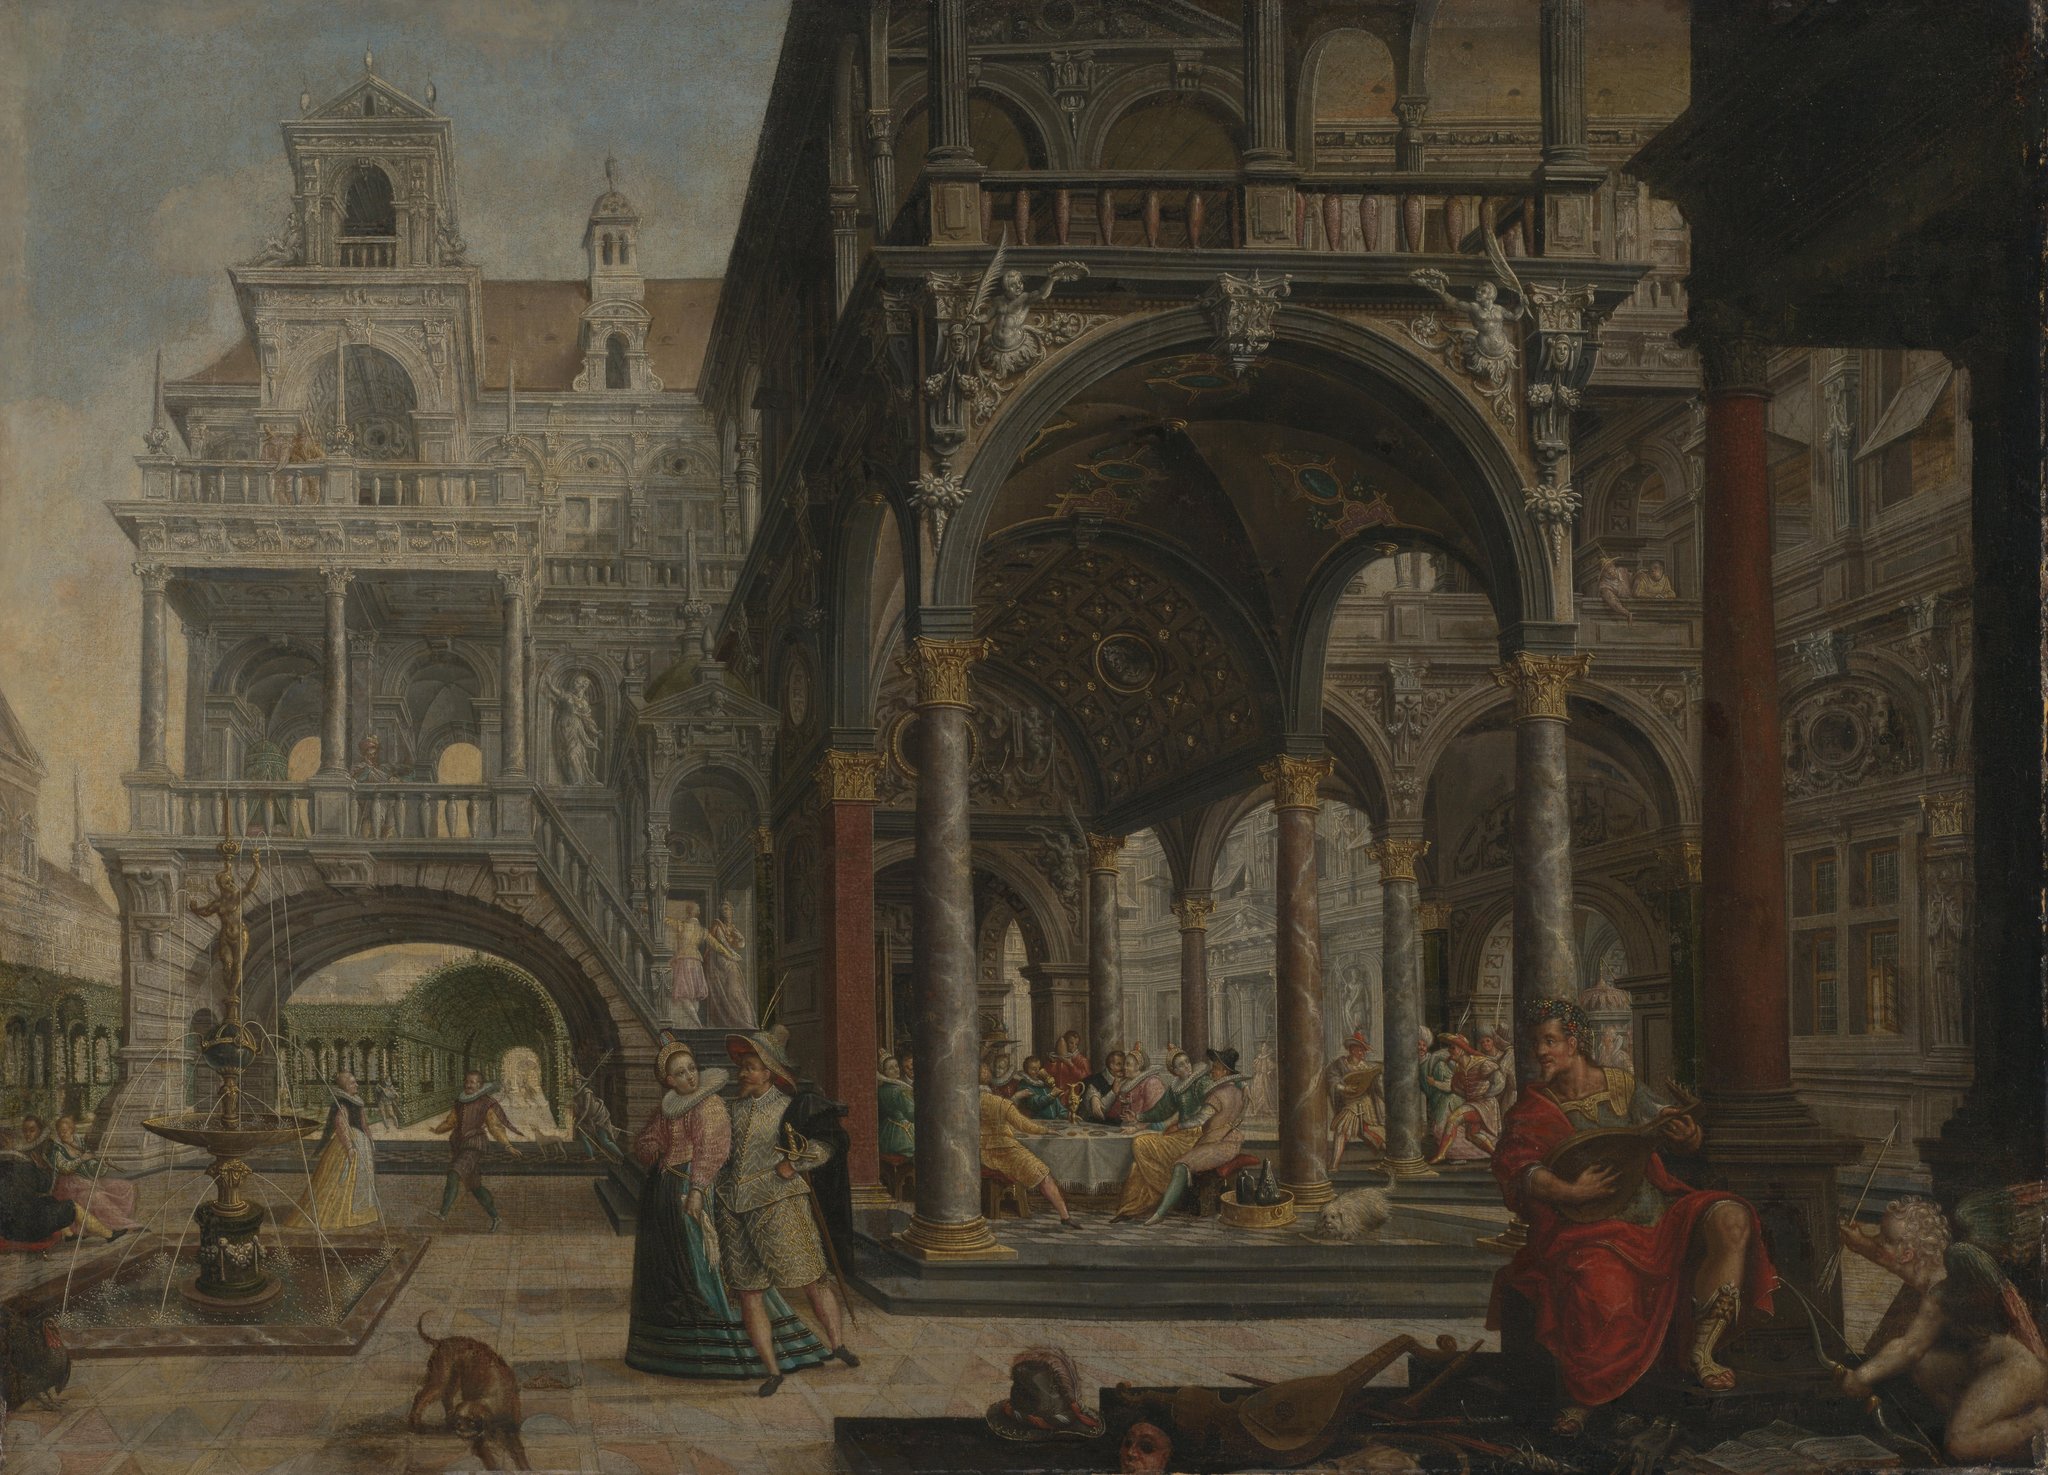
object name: painting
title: Imaginary Renaissance Palace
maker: hendrick aerts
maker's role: painter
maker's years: 1565-1603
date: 1602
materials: canvas, oil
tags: palace - aa - civic architecture: inside, banquet of elegant company, fantastic architecture, unrealistic architectural fantasies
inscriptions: signature and date: ‘HAerts Inv. 1602’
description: Hendrick Aerts. Imaginary Renaissance palace 1602. Canvas.